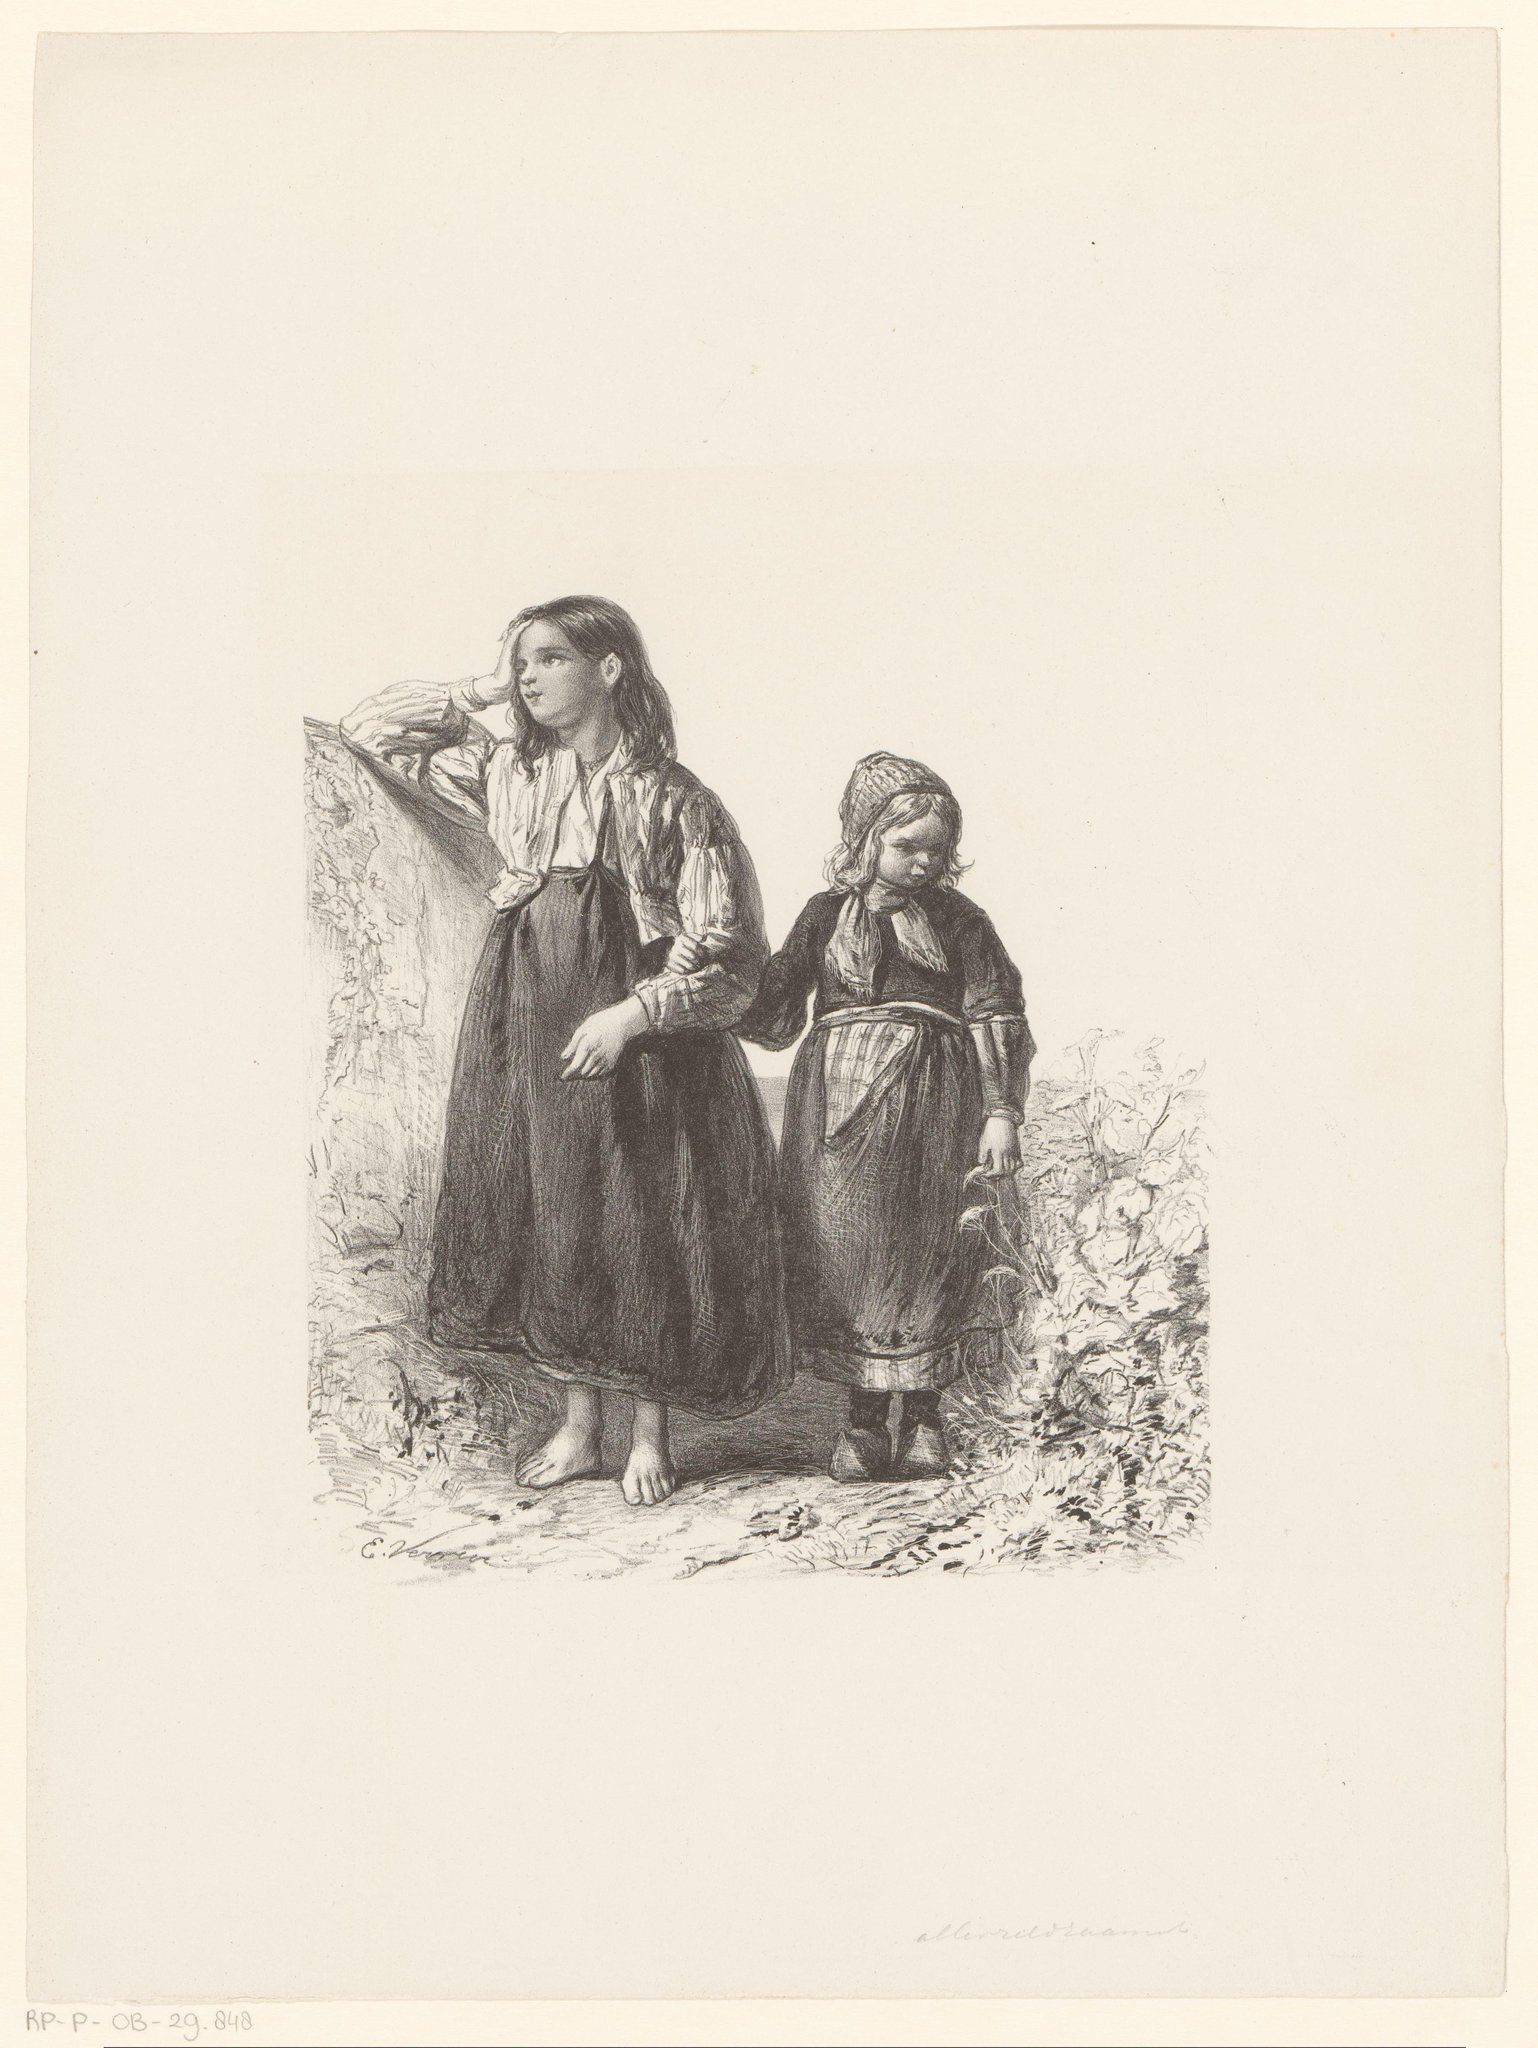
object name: print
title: Twee meisjes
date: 1836-1900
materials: paper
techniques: lithograph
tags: girl (child between toddler and youth)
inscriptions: collector's mark: Lugt 2228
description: Twee meisjes staan arm in arm in een landschap. Het meisje links, op blote voeten, staat geleund tegen een steen.